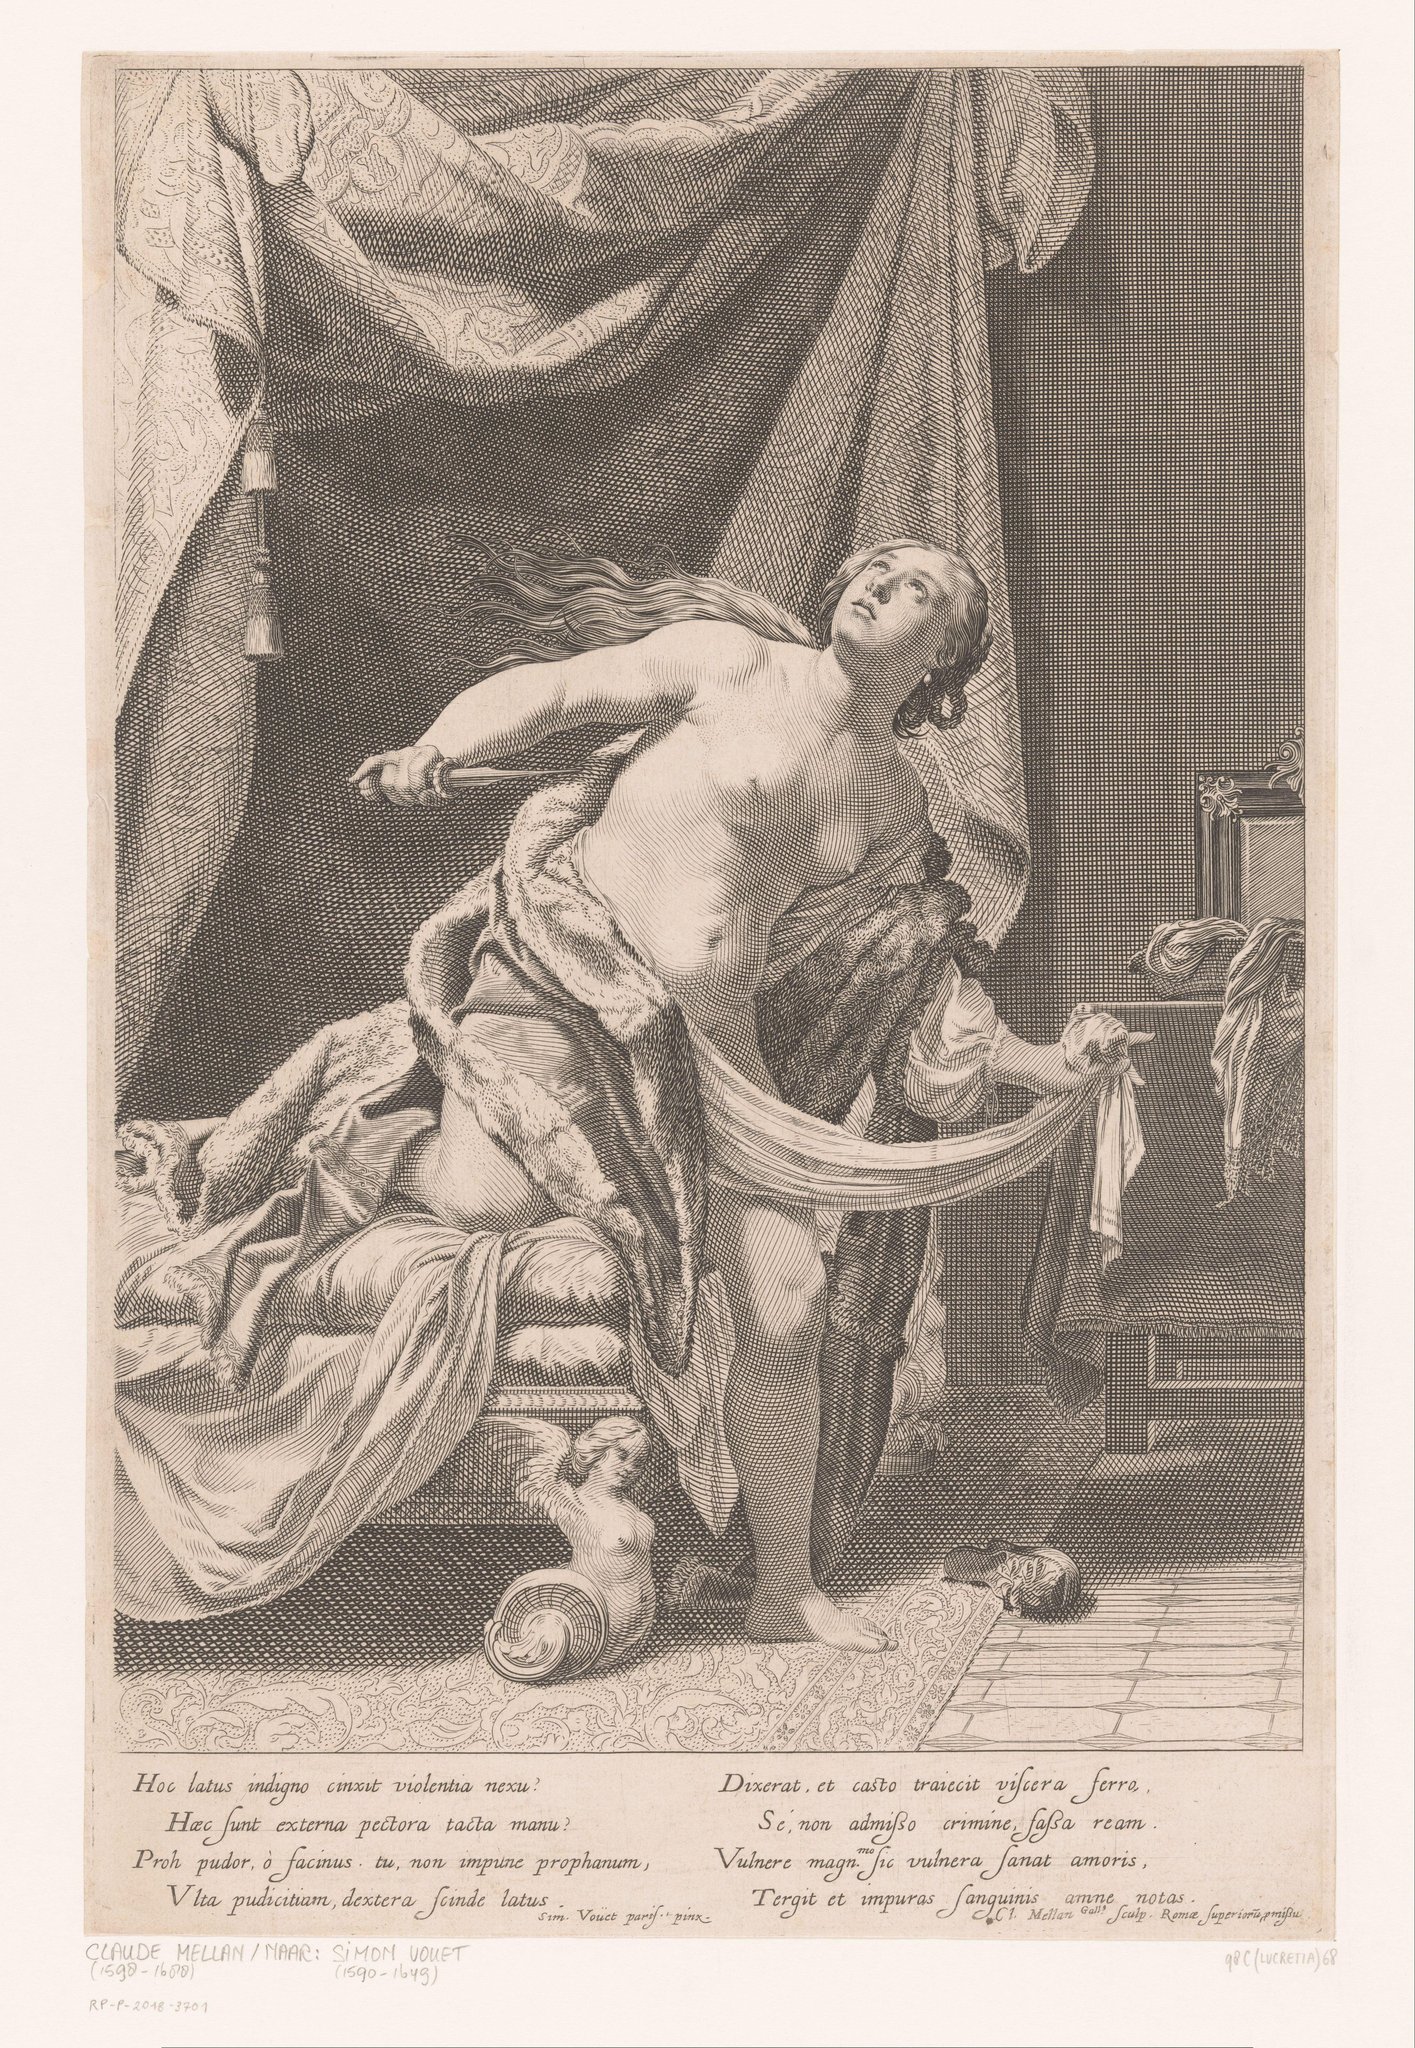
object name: print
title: Zelfmoord van Lucretia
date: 1624-1636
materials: paper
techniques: engraving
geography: rome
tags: death of lucretia: she commits suicide by stabbing herself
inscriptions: collector's mark: Lugt 2228